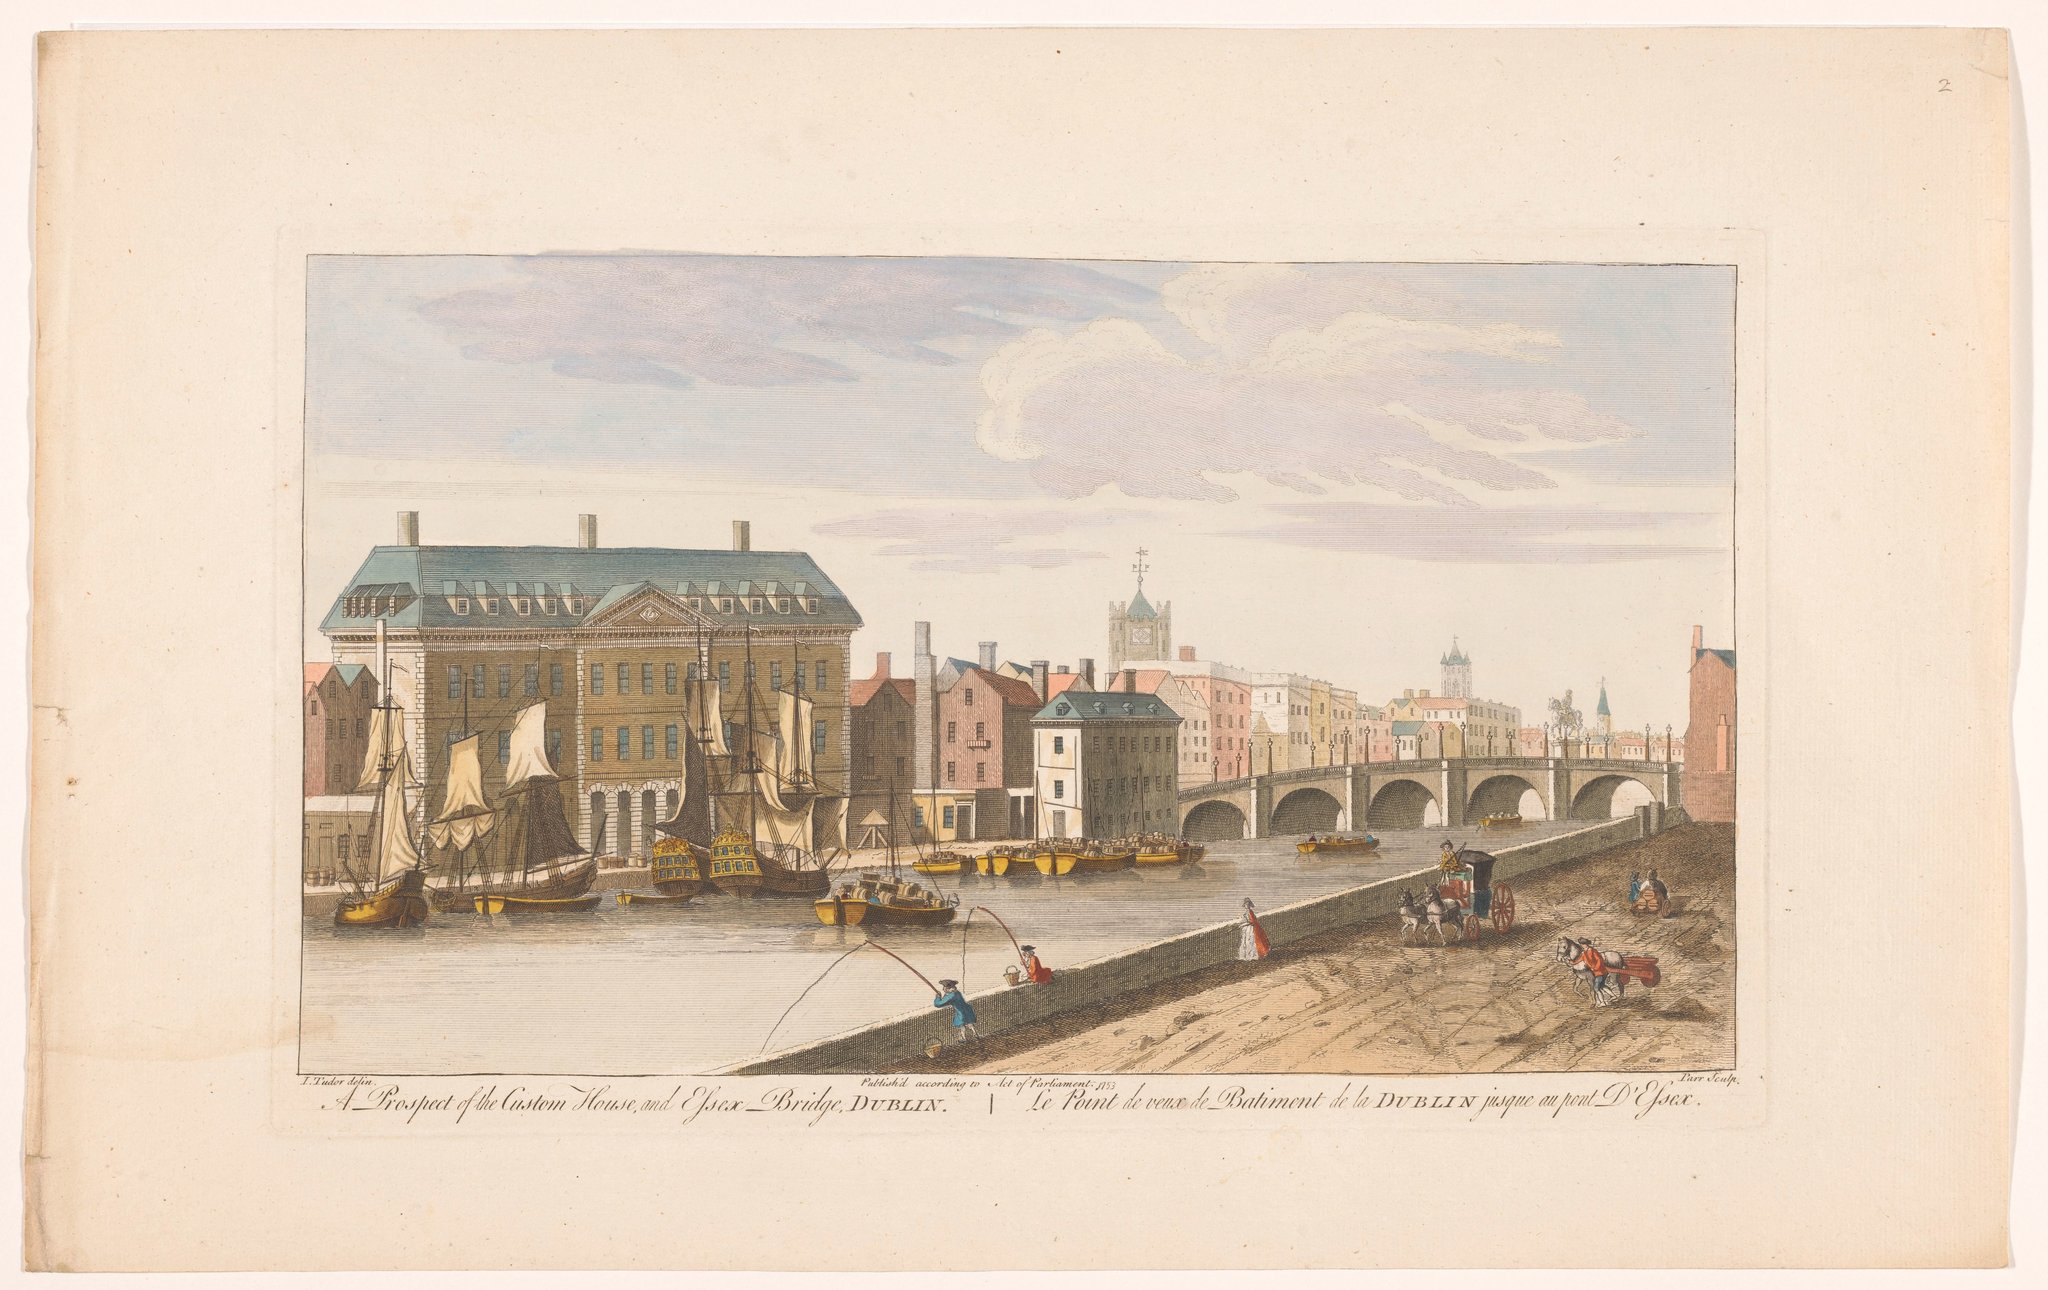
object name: opticaprent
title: A prospect of the Custom House, and Essex Bridge, Dublin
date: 1753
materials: paper, watercolor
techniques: brush, etching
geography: england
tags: bridge in city across river, canal, etc. (+ city(-scape) with figures, staffage), sailing-ship, sailing-boat, rowing-boat, canoe, etc., taxes and financial administration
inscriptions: watermark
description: De serie “Ierland” bevat zes prenten met de nummers 1-6, waarvan dit mogelijk nummer 2 is.